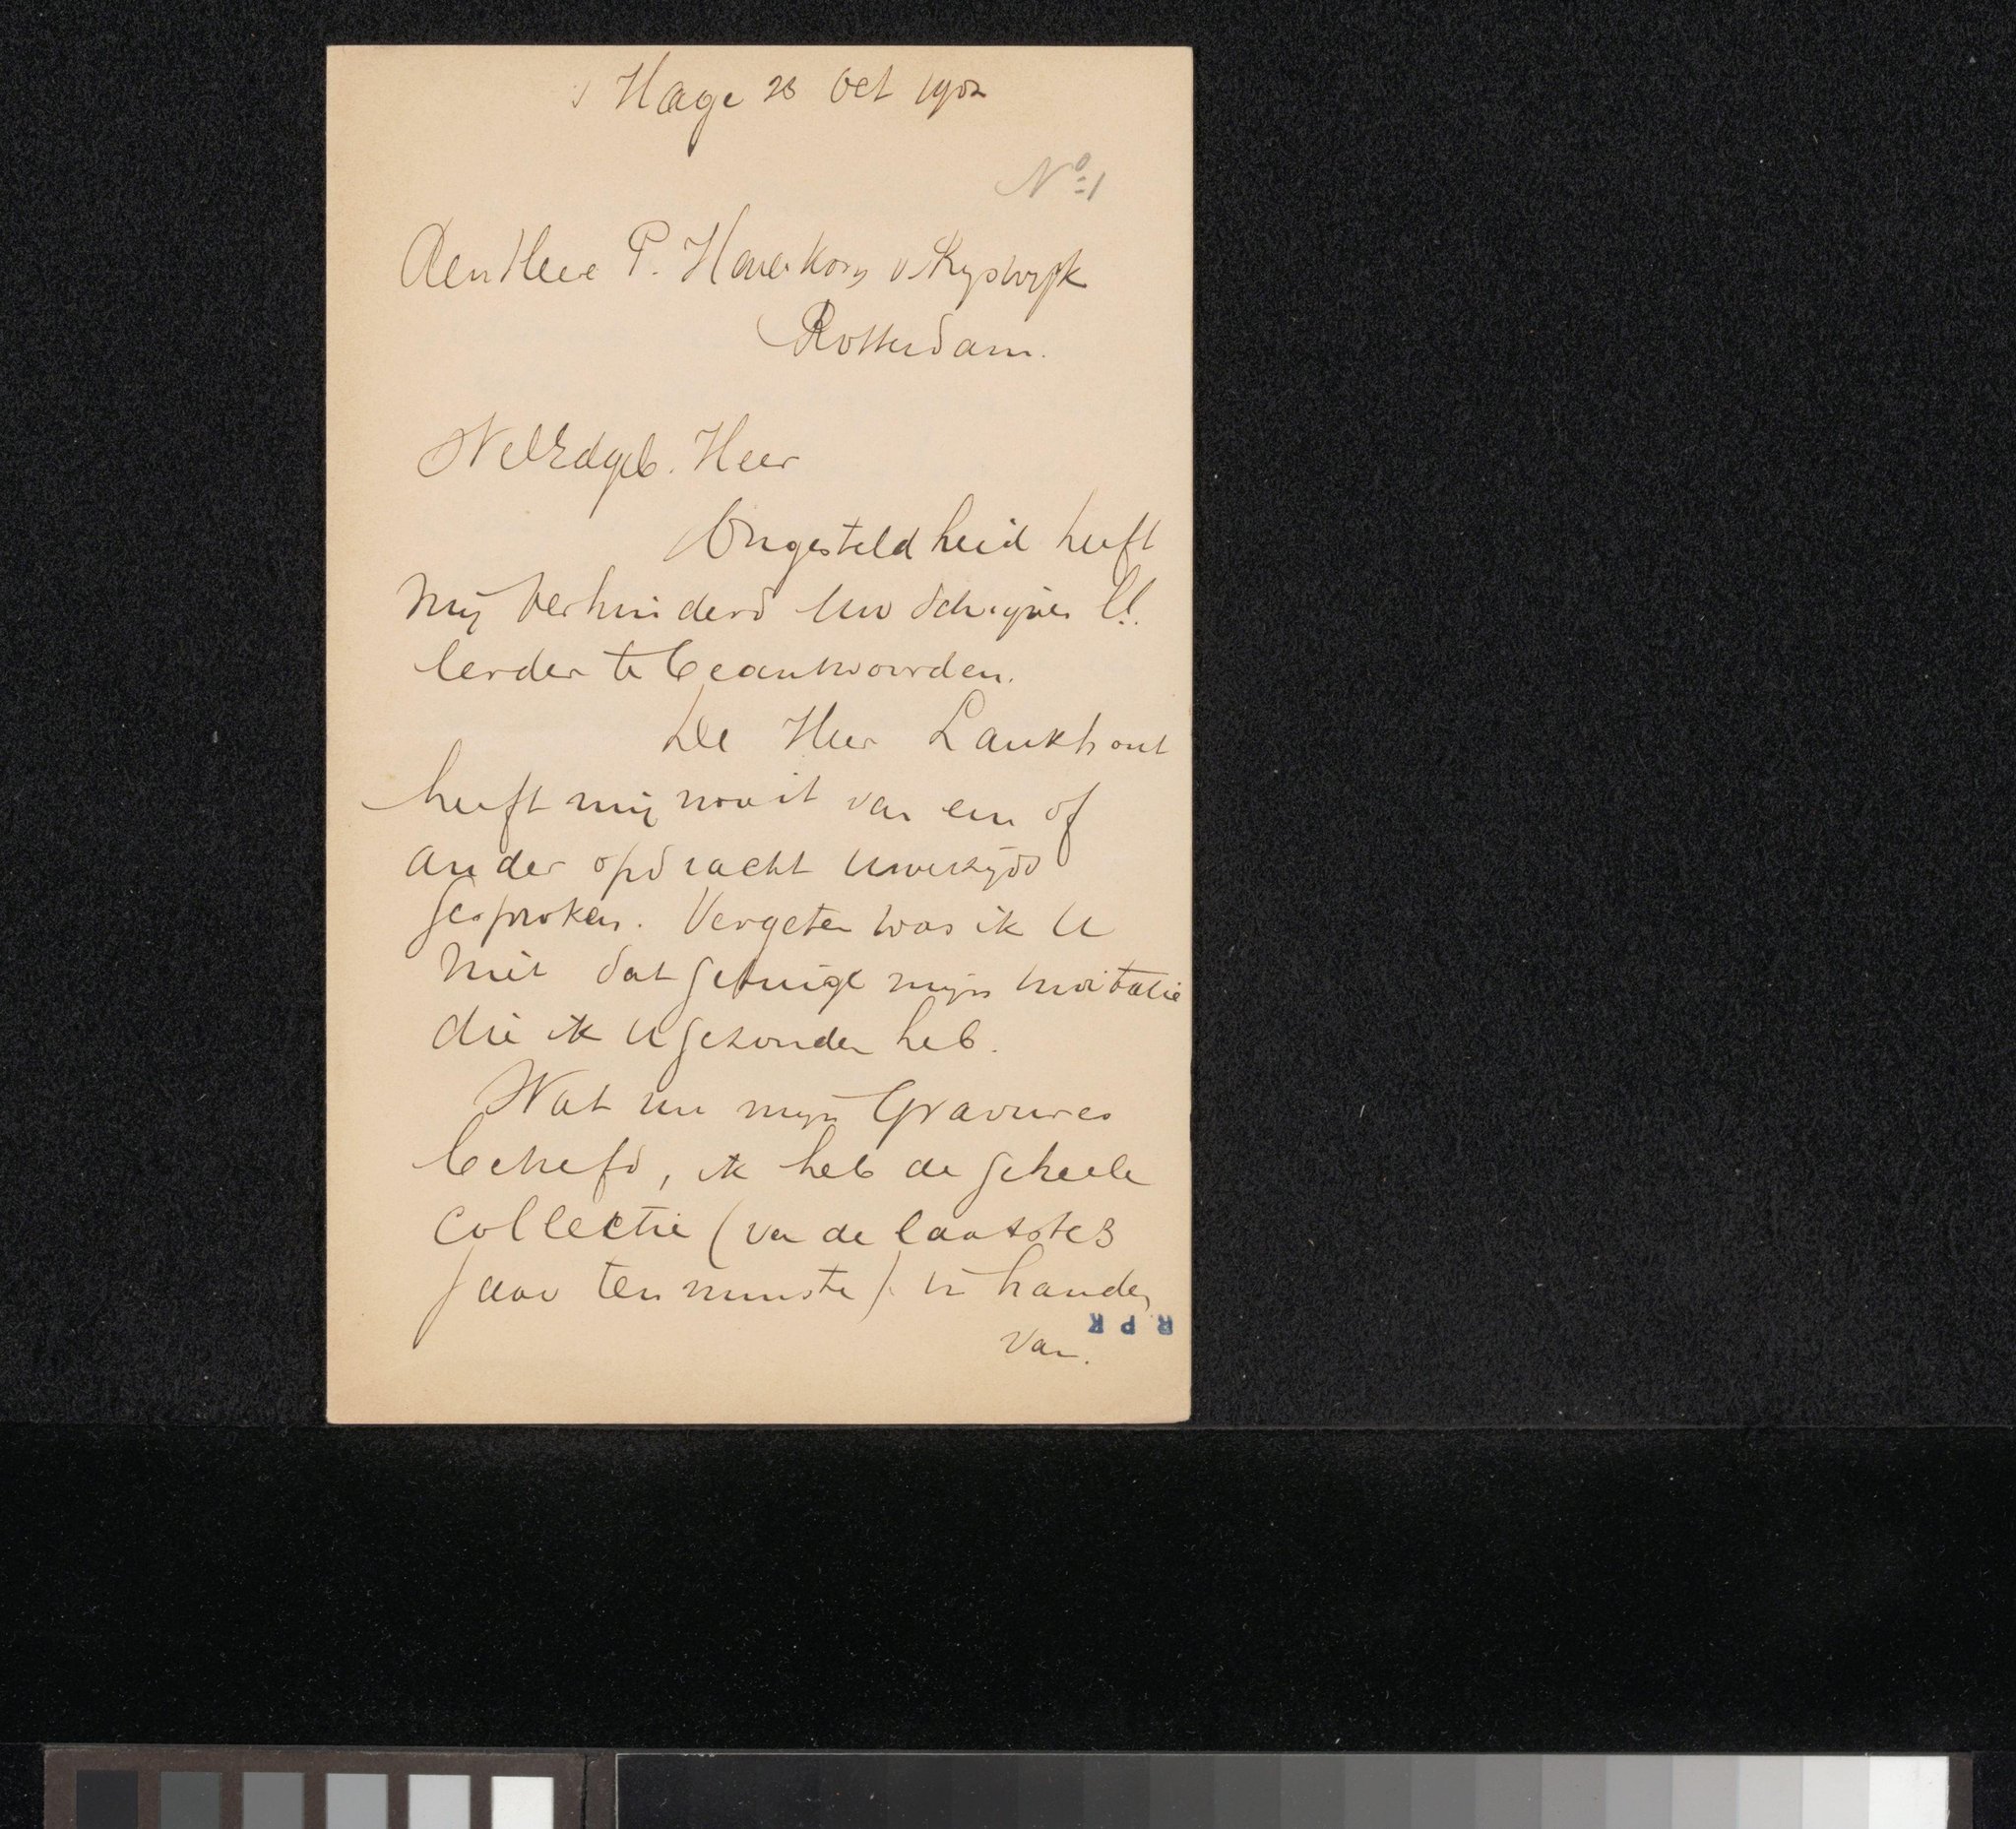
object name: letter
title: Brief aan Pieter Haverkorn van Rijsewijk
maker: johannes josephus aarts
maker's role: draughtsman, print maker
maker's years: 1871-1934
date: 1902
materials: ink, paper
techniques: pen, writing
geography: the hague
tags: pieter haverkorn van rijsewijk, the hague, draughtsman, printer, henri lankhout, the graphic arts, exhibition ~ art, diseases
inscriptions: collector's mark: Lugt 2233